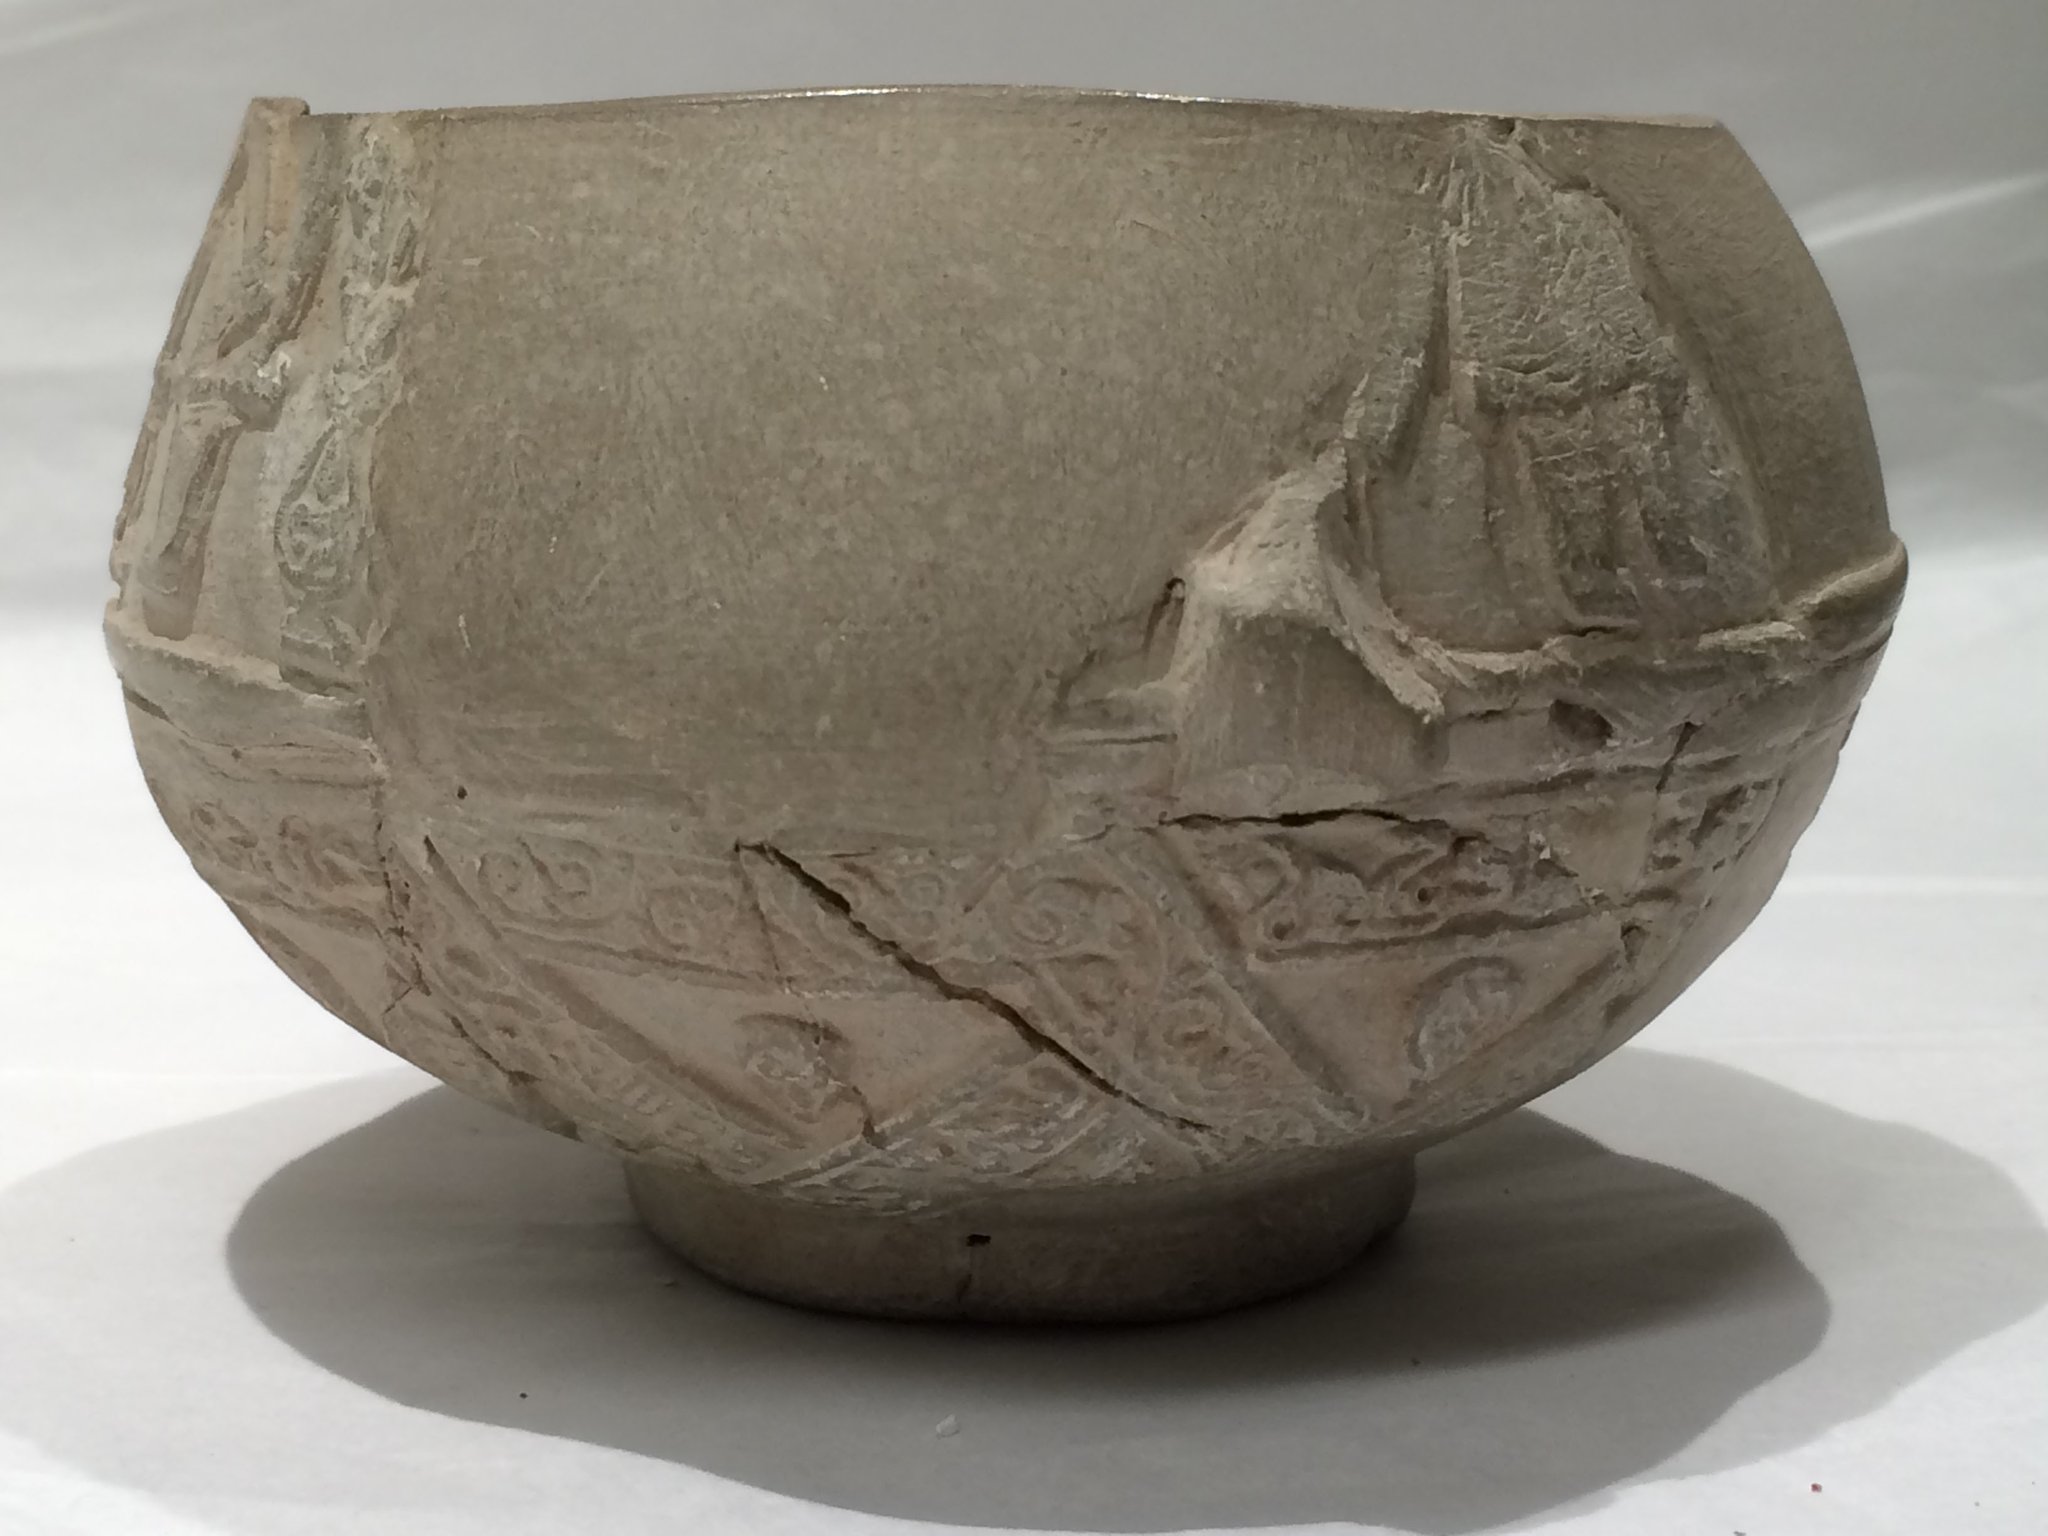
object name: fragment of an ewer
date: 1001-1200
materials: earthenware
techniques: molding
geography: iran